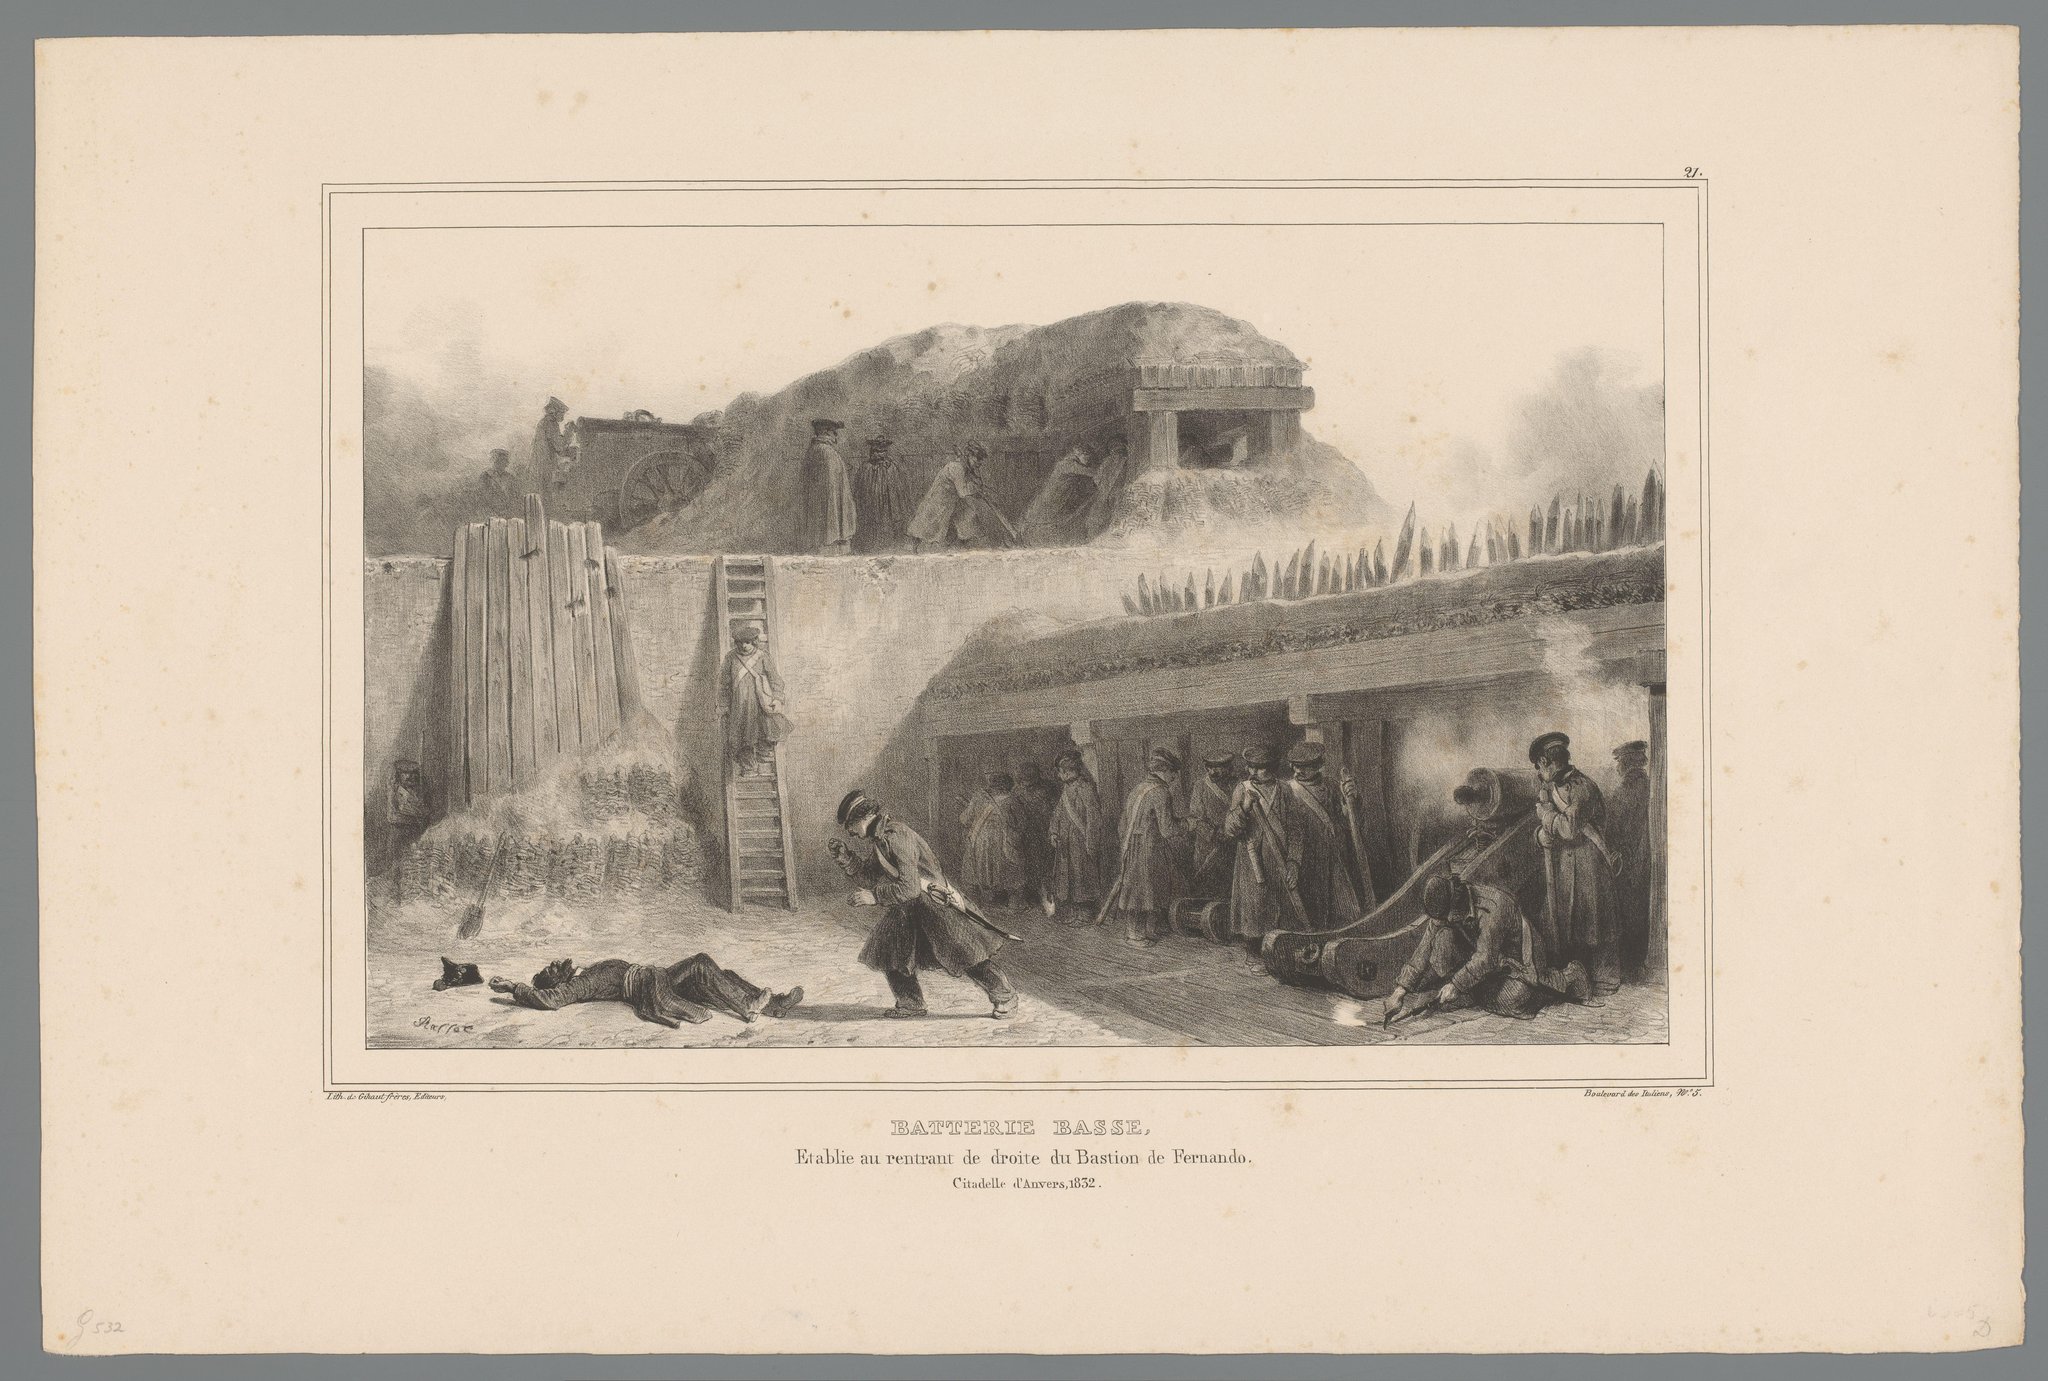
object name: print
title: Dessins faits d'après nature au siège de la Citadelle d'Anvers par Raffet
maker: denis auguste marie raffet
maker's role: draughtsman, print maker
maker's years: 1804-1860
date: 1833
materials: paper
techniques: lithograph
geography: paris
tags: siege, position war, fortifications, military engineering, firearms: cannon, the soldier; the soldier's life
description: Soldaten bezig bij een rij kanonnen; links op de voorgrond ligt een gewonde. Onderdeel van de serie van 24 prenten over het beleg van de Citadel van Antwerpen, 30 november - 23 december 1832.